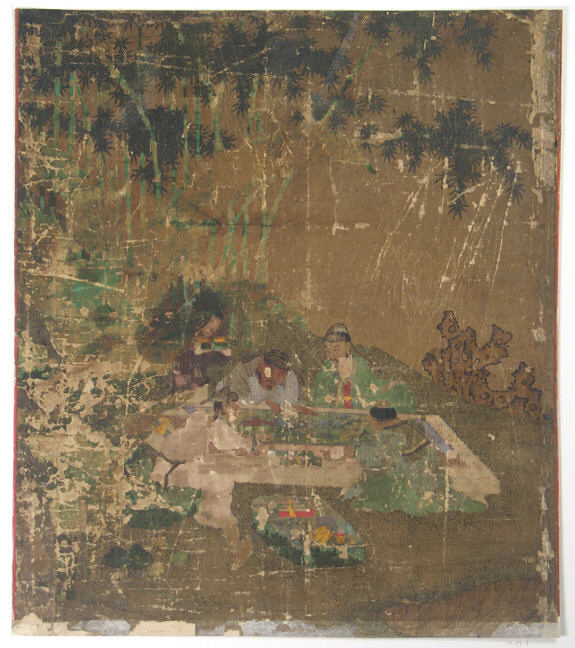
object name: album leaf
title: Examining Antiques at Literati Gathering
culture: korean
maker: wang li mu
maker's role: artist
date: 1701-1800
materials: ink, silk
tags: men